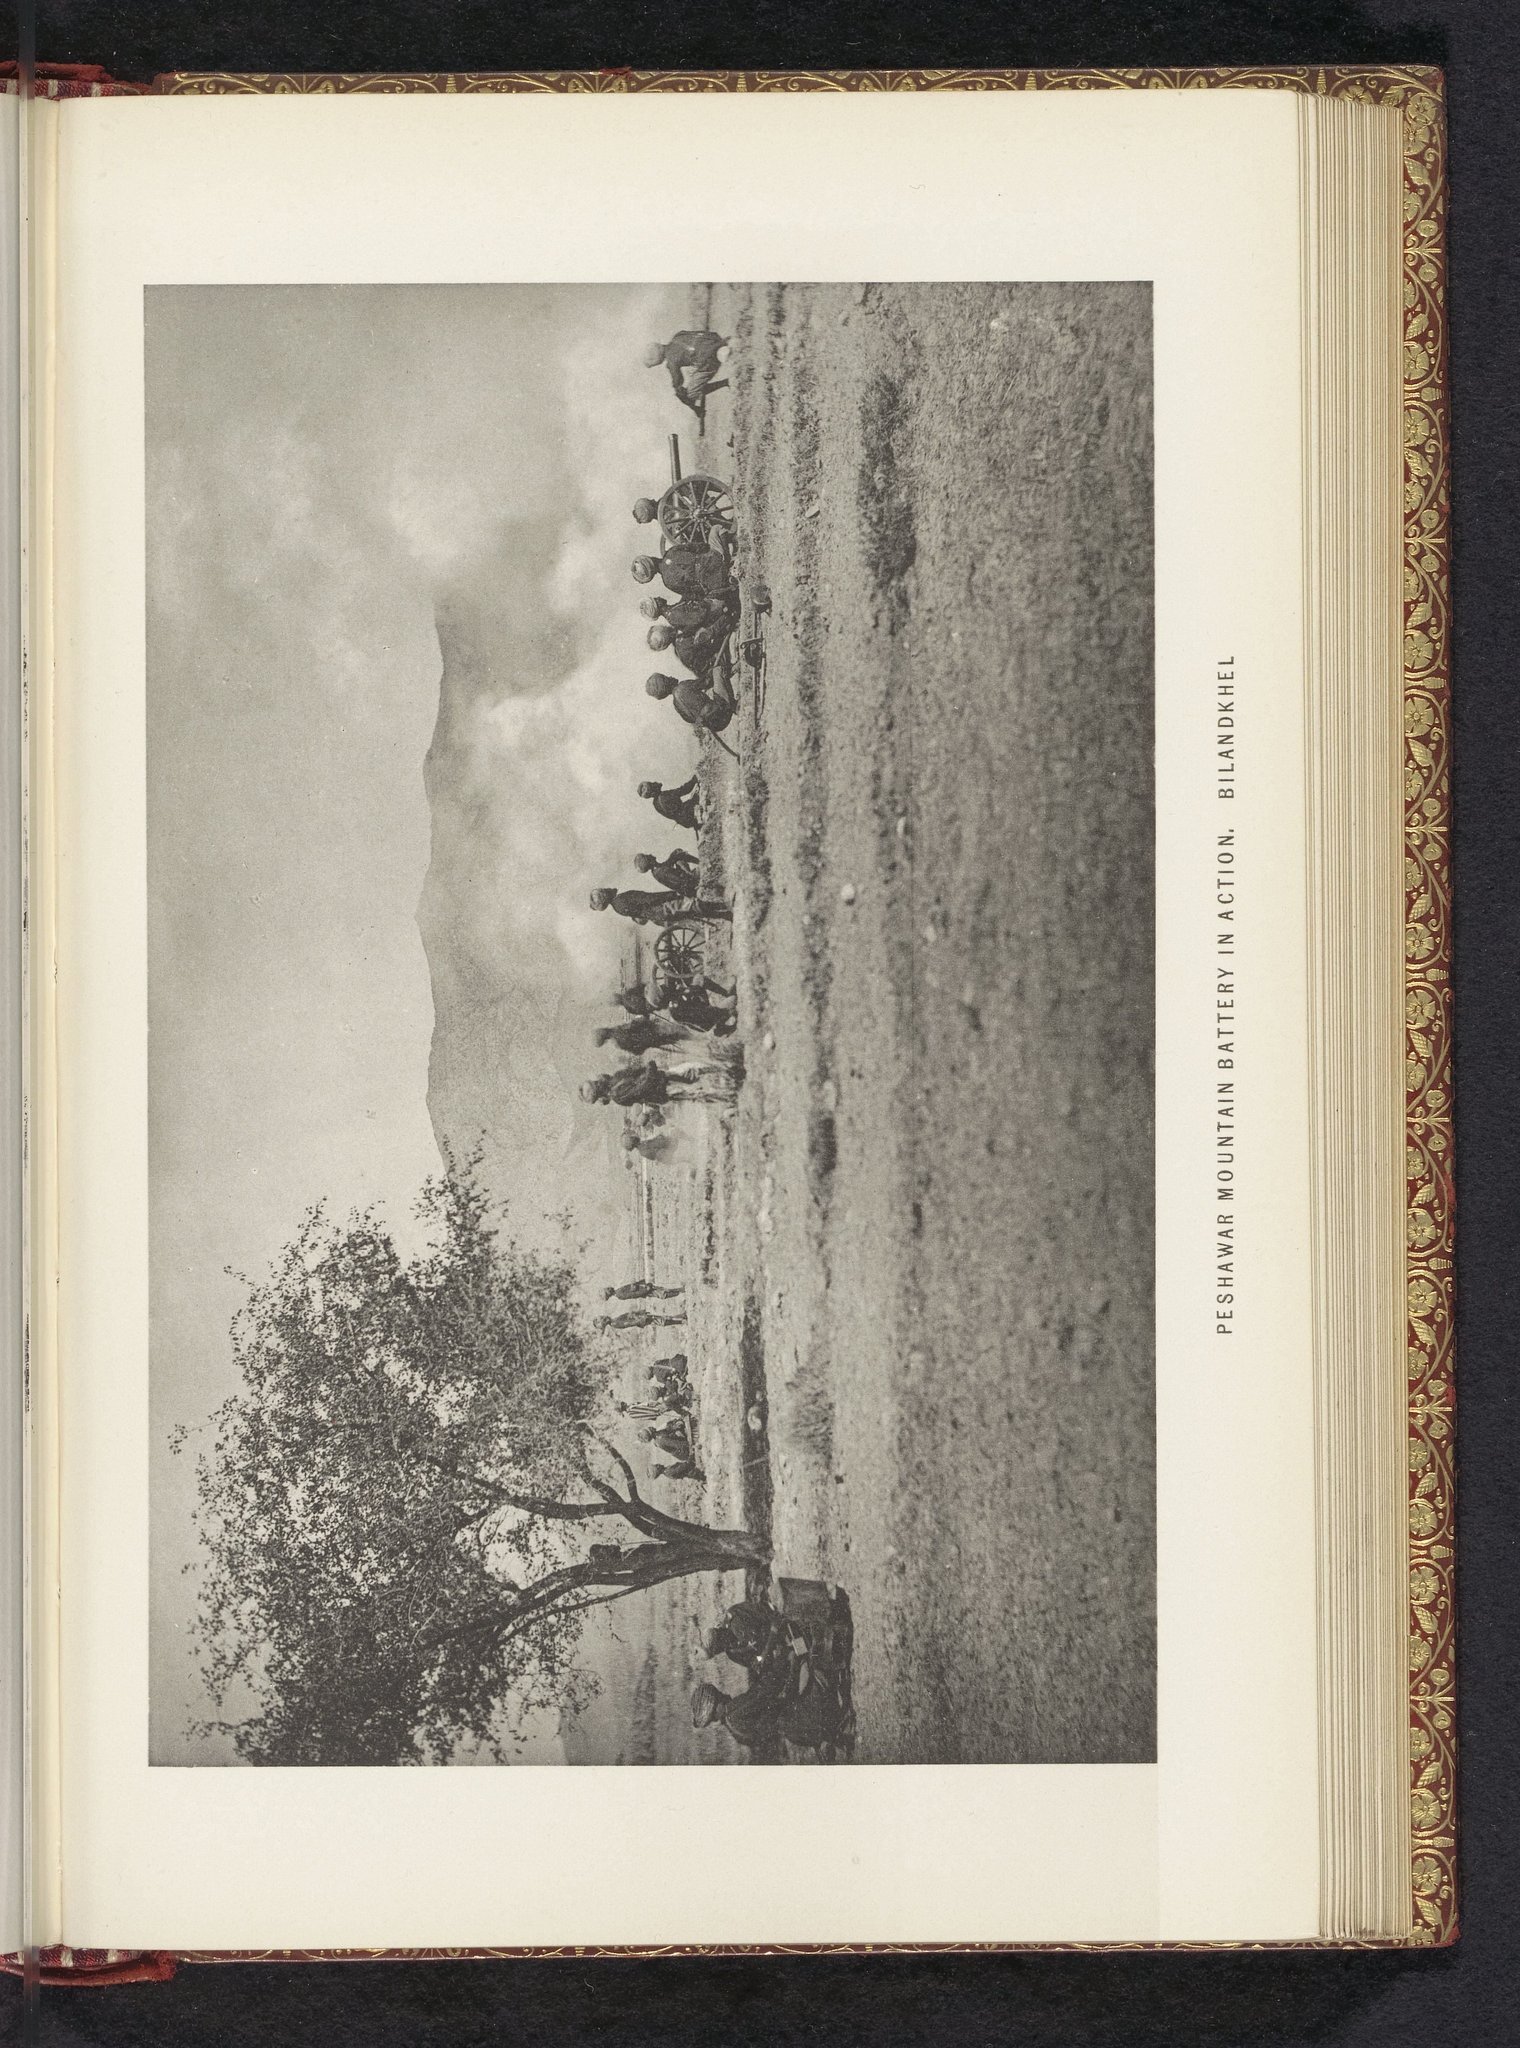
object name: page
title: View of gun firing at Biland Khel, Khyber Pakhtunkhwa, Pakistan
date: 1890-1895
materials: paper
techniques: photograph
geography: biland khel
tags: firearms: cannon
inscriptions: caption, q: ‘PESHAWAR MOUNTAIN BATTERY IN ACTION. BILANDKHEL’